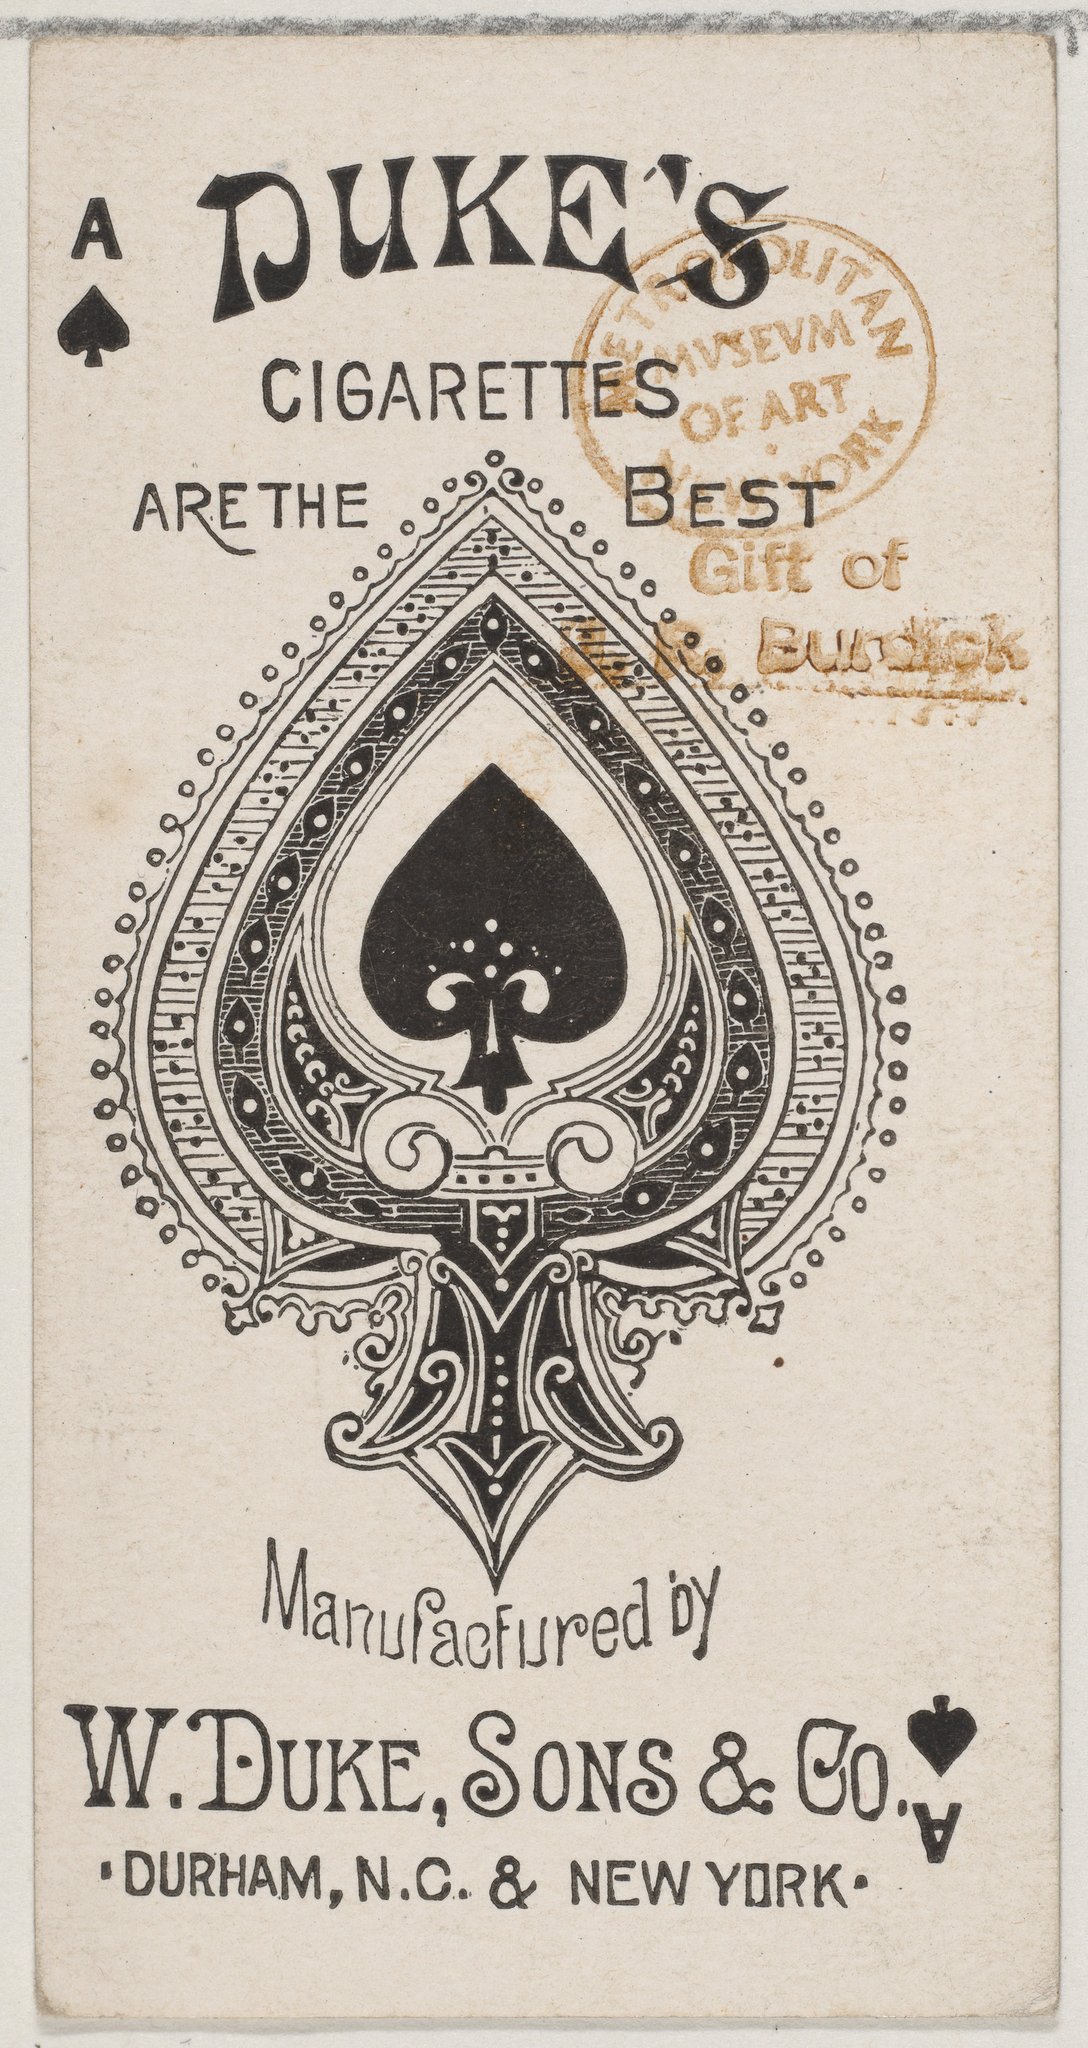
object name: print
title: Ace of Spades (black), from the Playing Cards series (N84) for Duke brand cigarettes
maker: w. duke, sons & co.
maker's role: publisher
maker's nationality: american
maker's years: 1870-1920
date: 1888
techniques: color lithograph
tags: playing cards